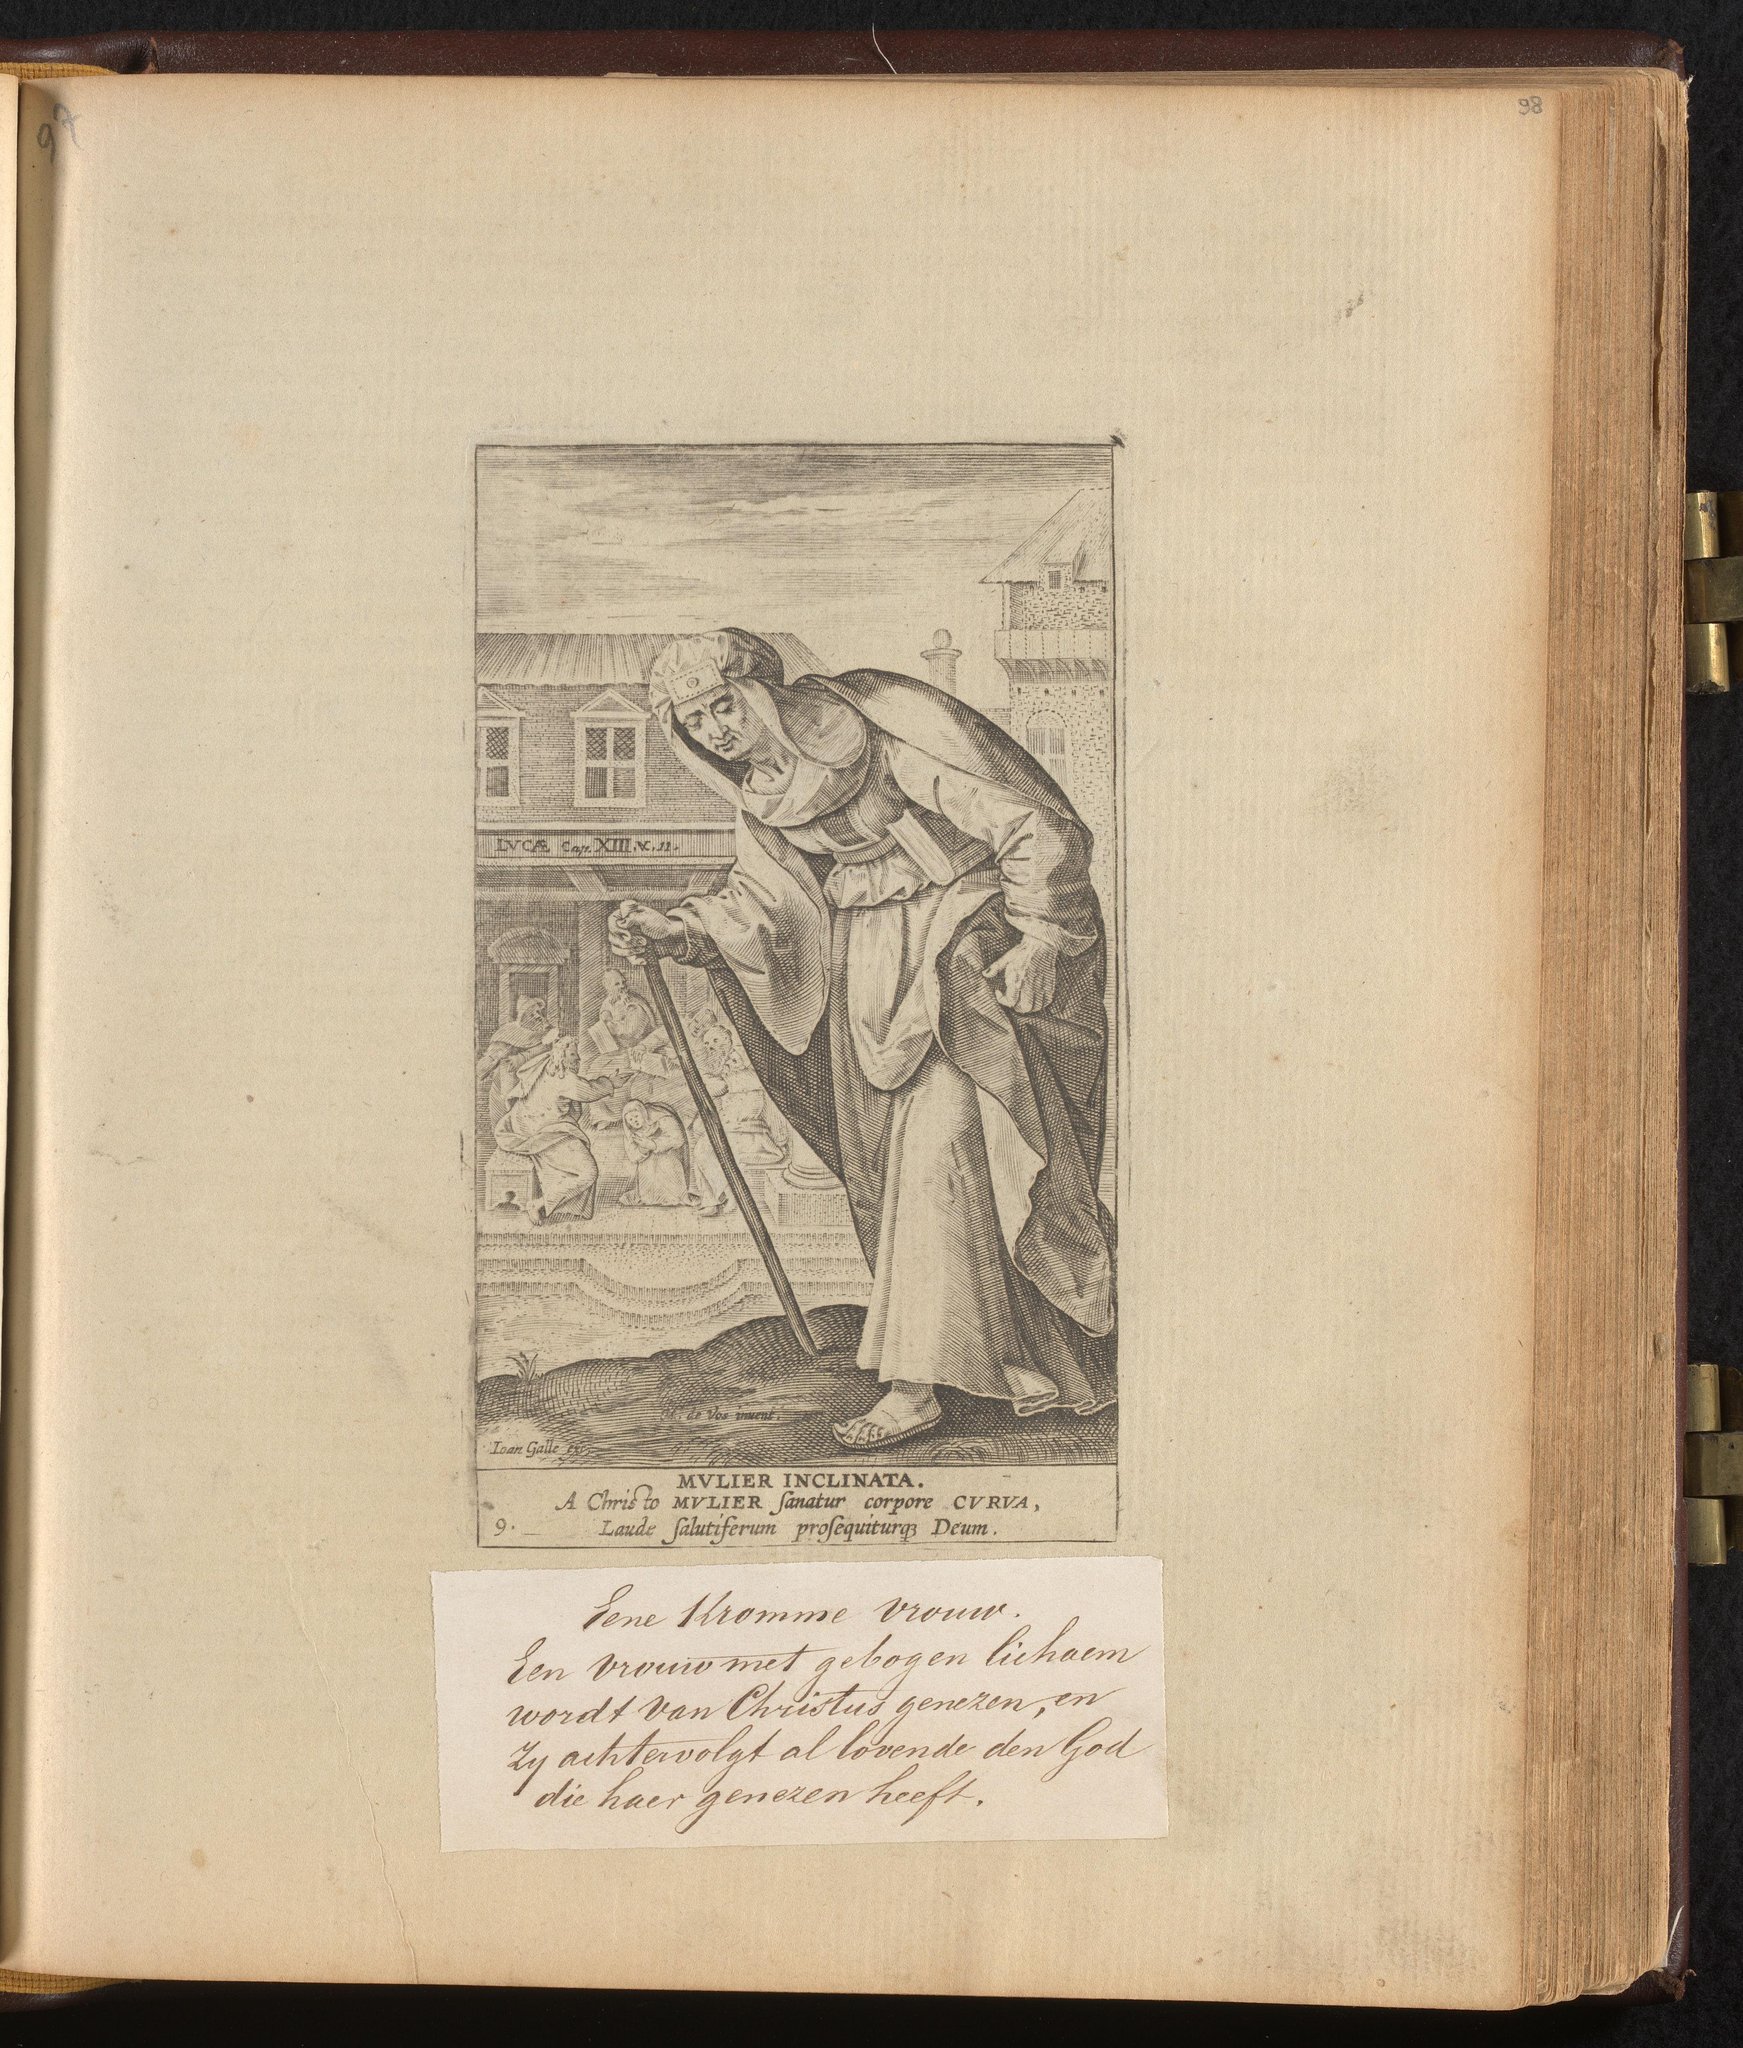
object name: album leaf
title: Icones Illvstrivm Feminarvm Novi Testamenti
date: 1599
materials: paper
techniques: engraving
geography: antwerp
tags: healing of a woman 'bent over' (luke 13:10-17)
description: Prent maakt deel uit van een prentbijbel.